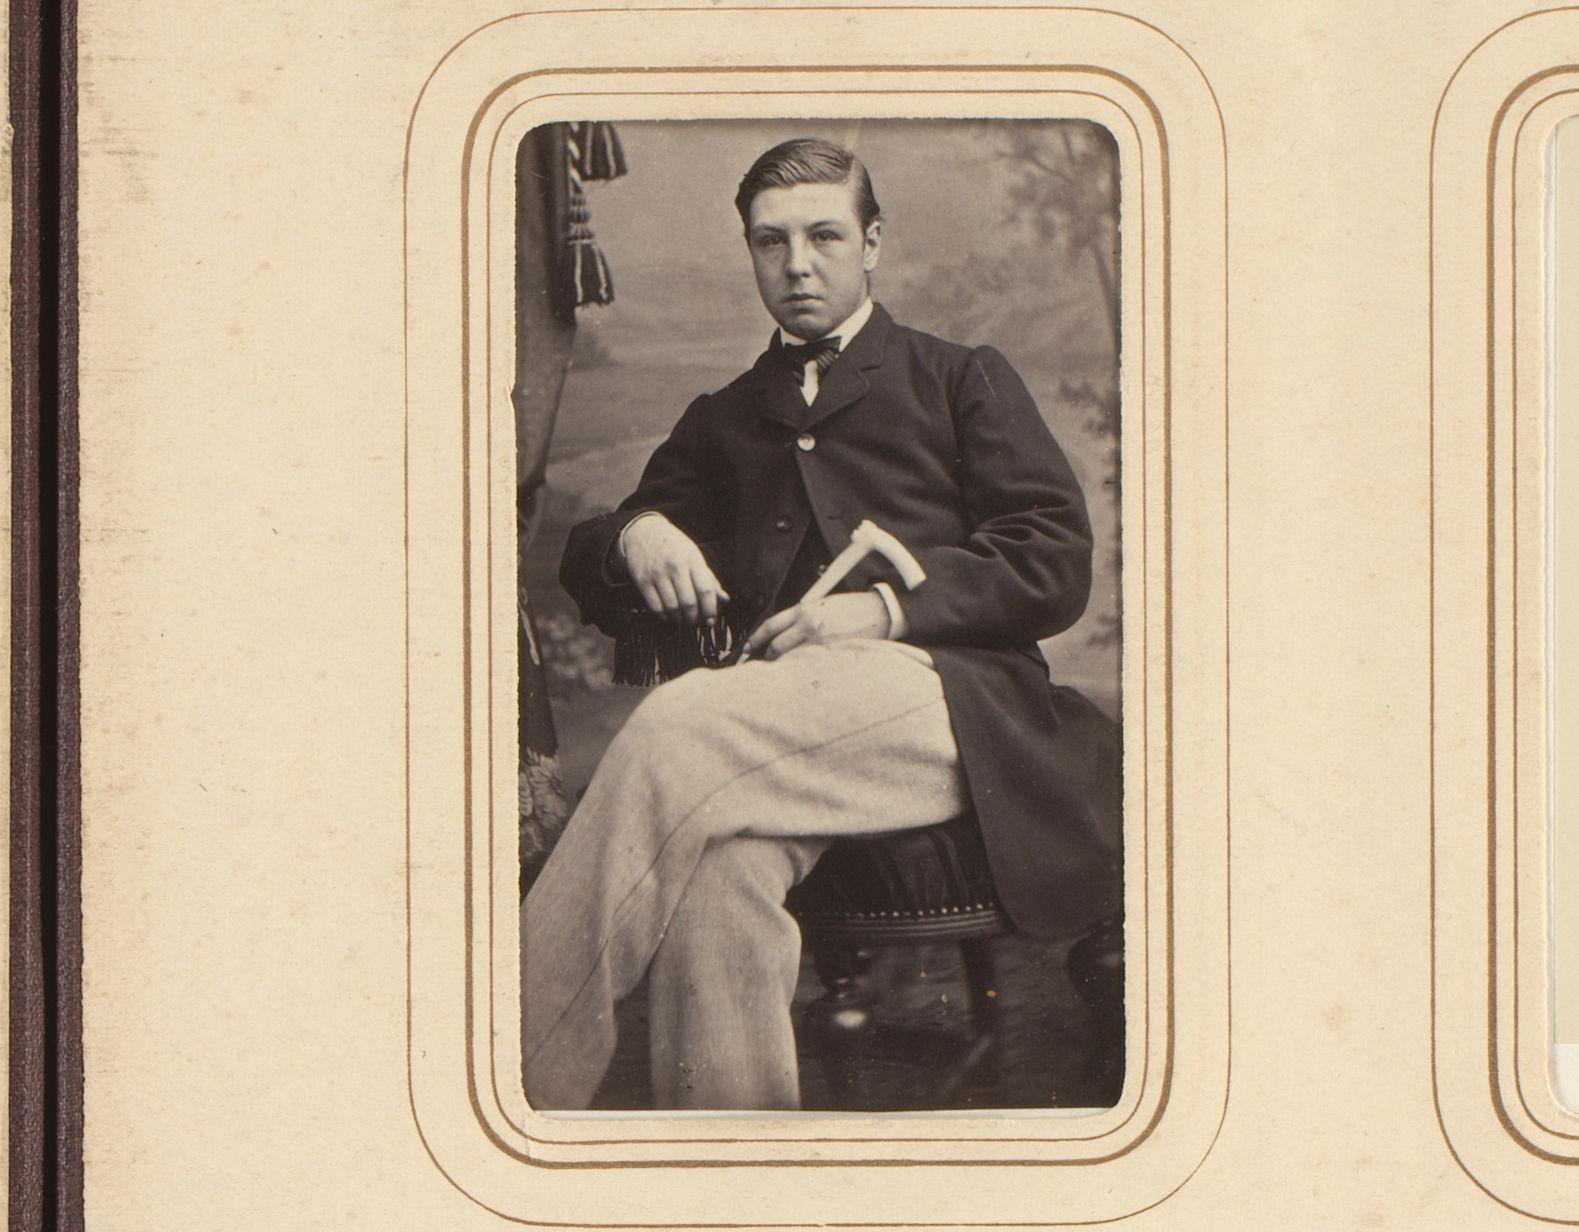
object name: photograph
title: Portret van Alex Grothe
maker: christien van leeuwen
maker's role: fotograaf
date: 1866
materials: cardboard, photographic support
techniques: albumen print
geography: utrecht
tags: adult man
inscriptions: inscription: ‘Christien / van Leeuwen. / Utrecht.’, annotation: ‘Alex Grothe/ 30 Mei 1866’